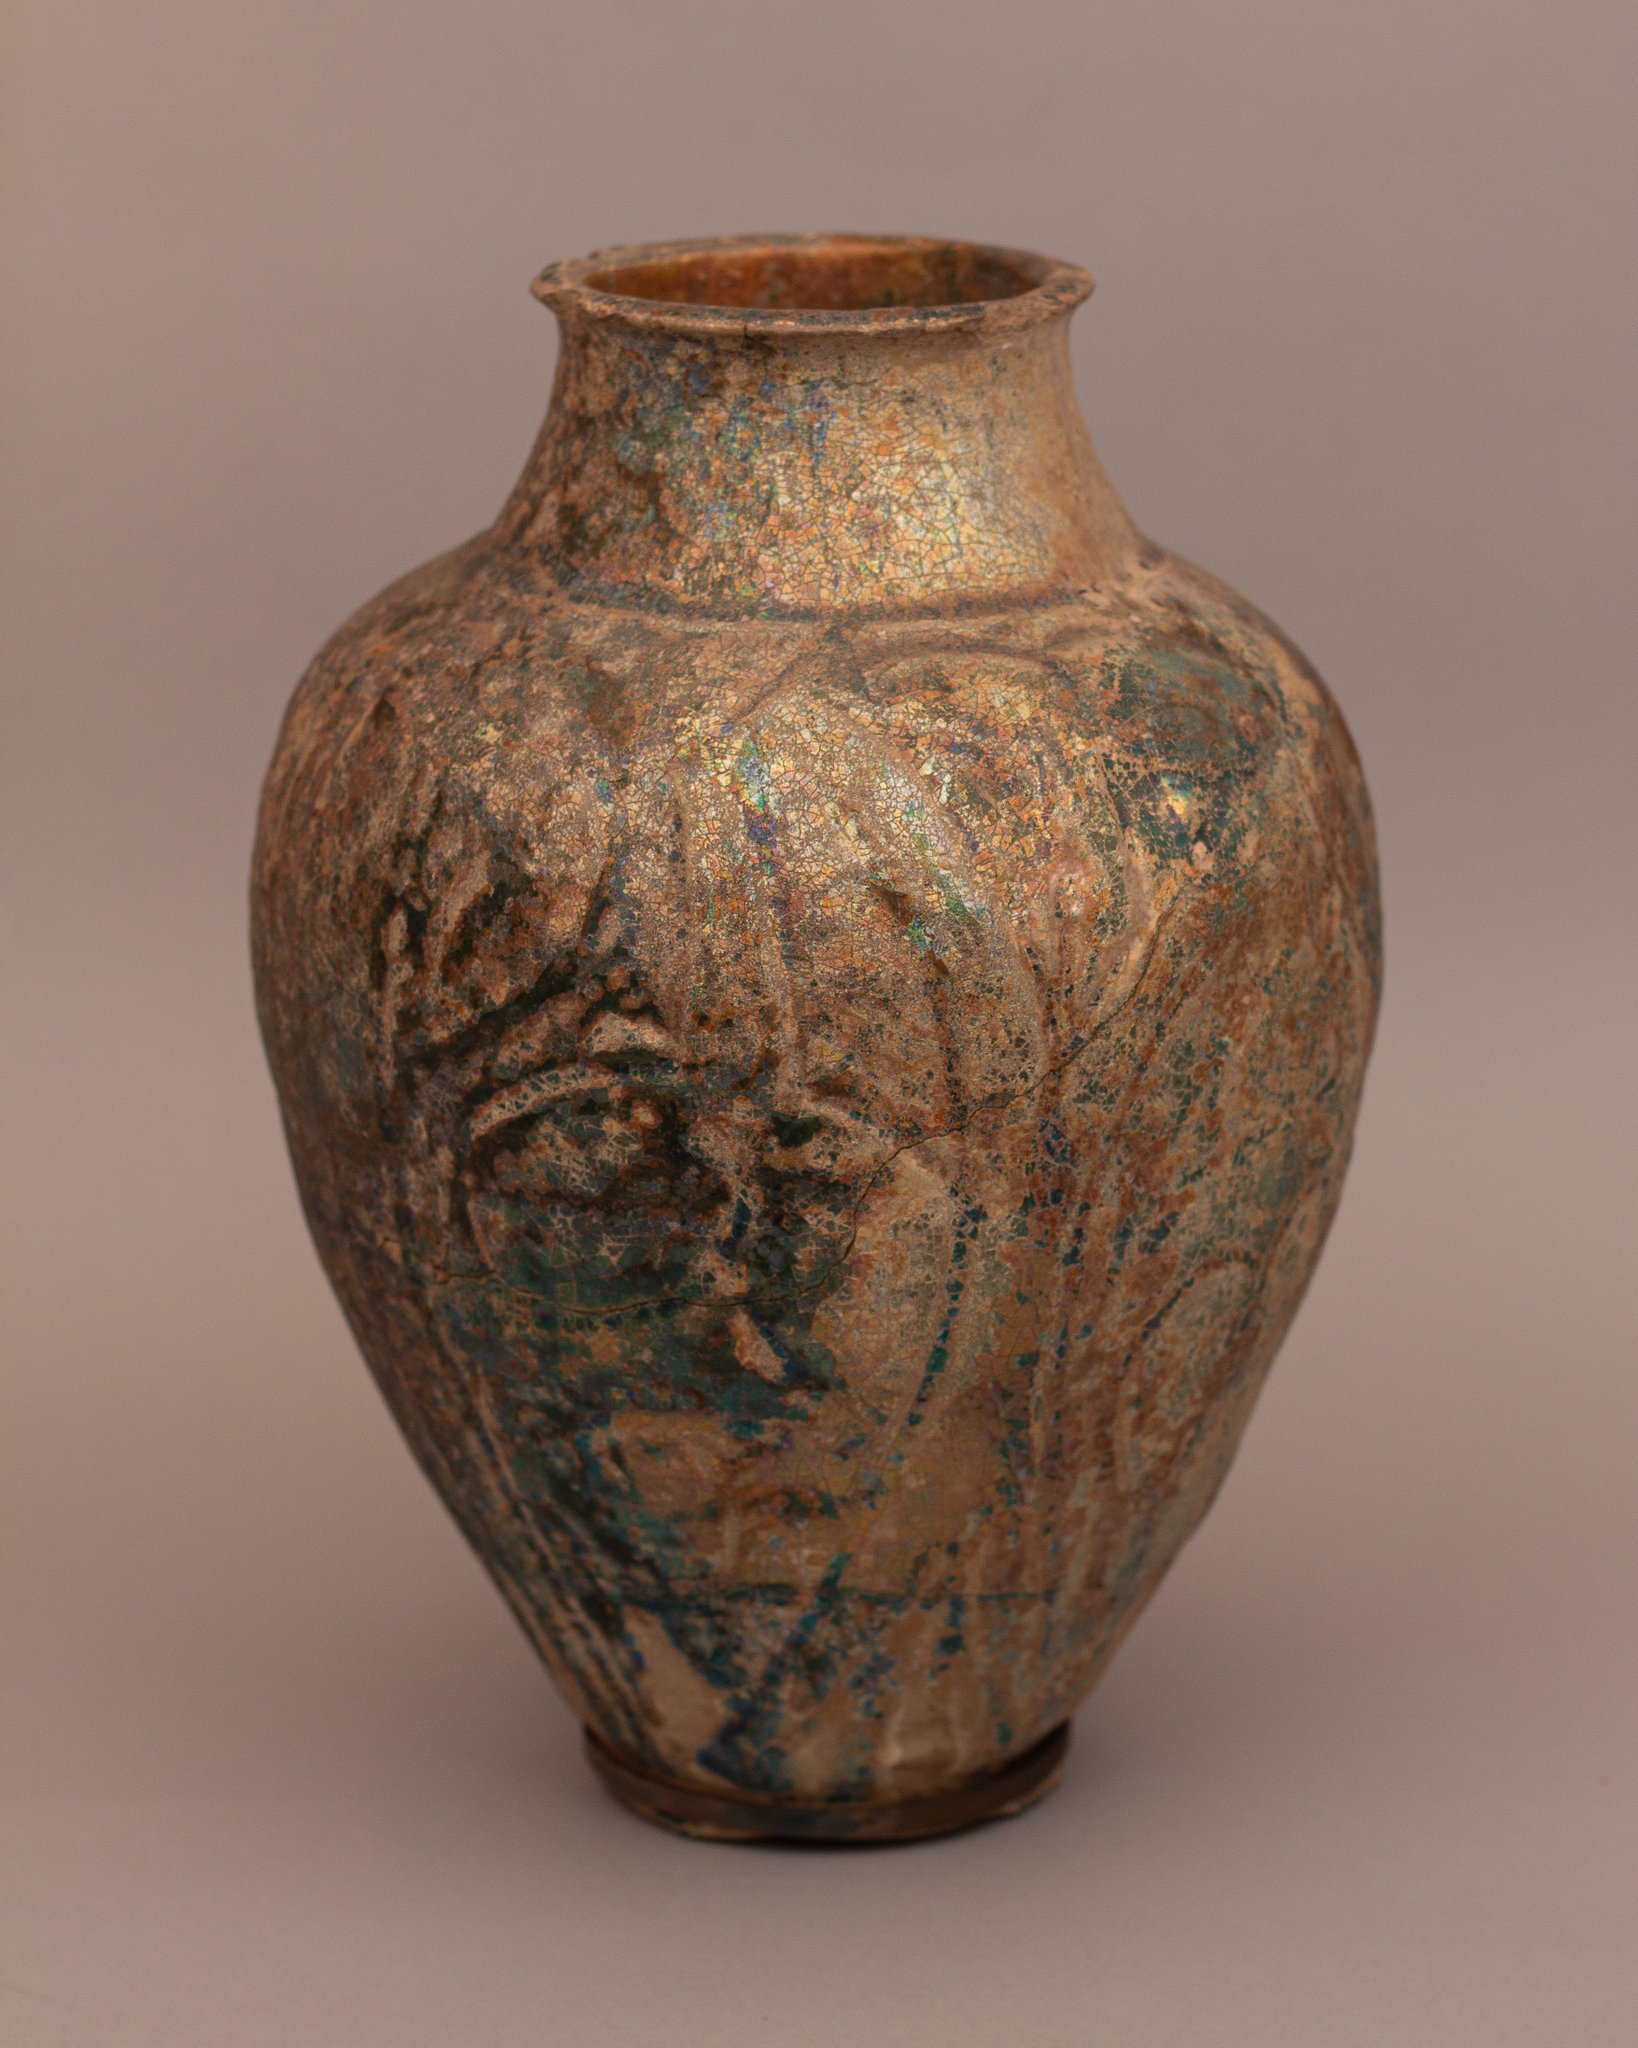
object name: jar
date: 1101-1200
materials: earthenware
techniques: glazing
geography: syria